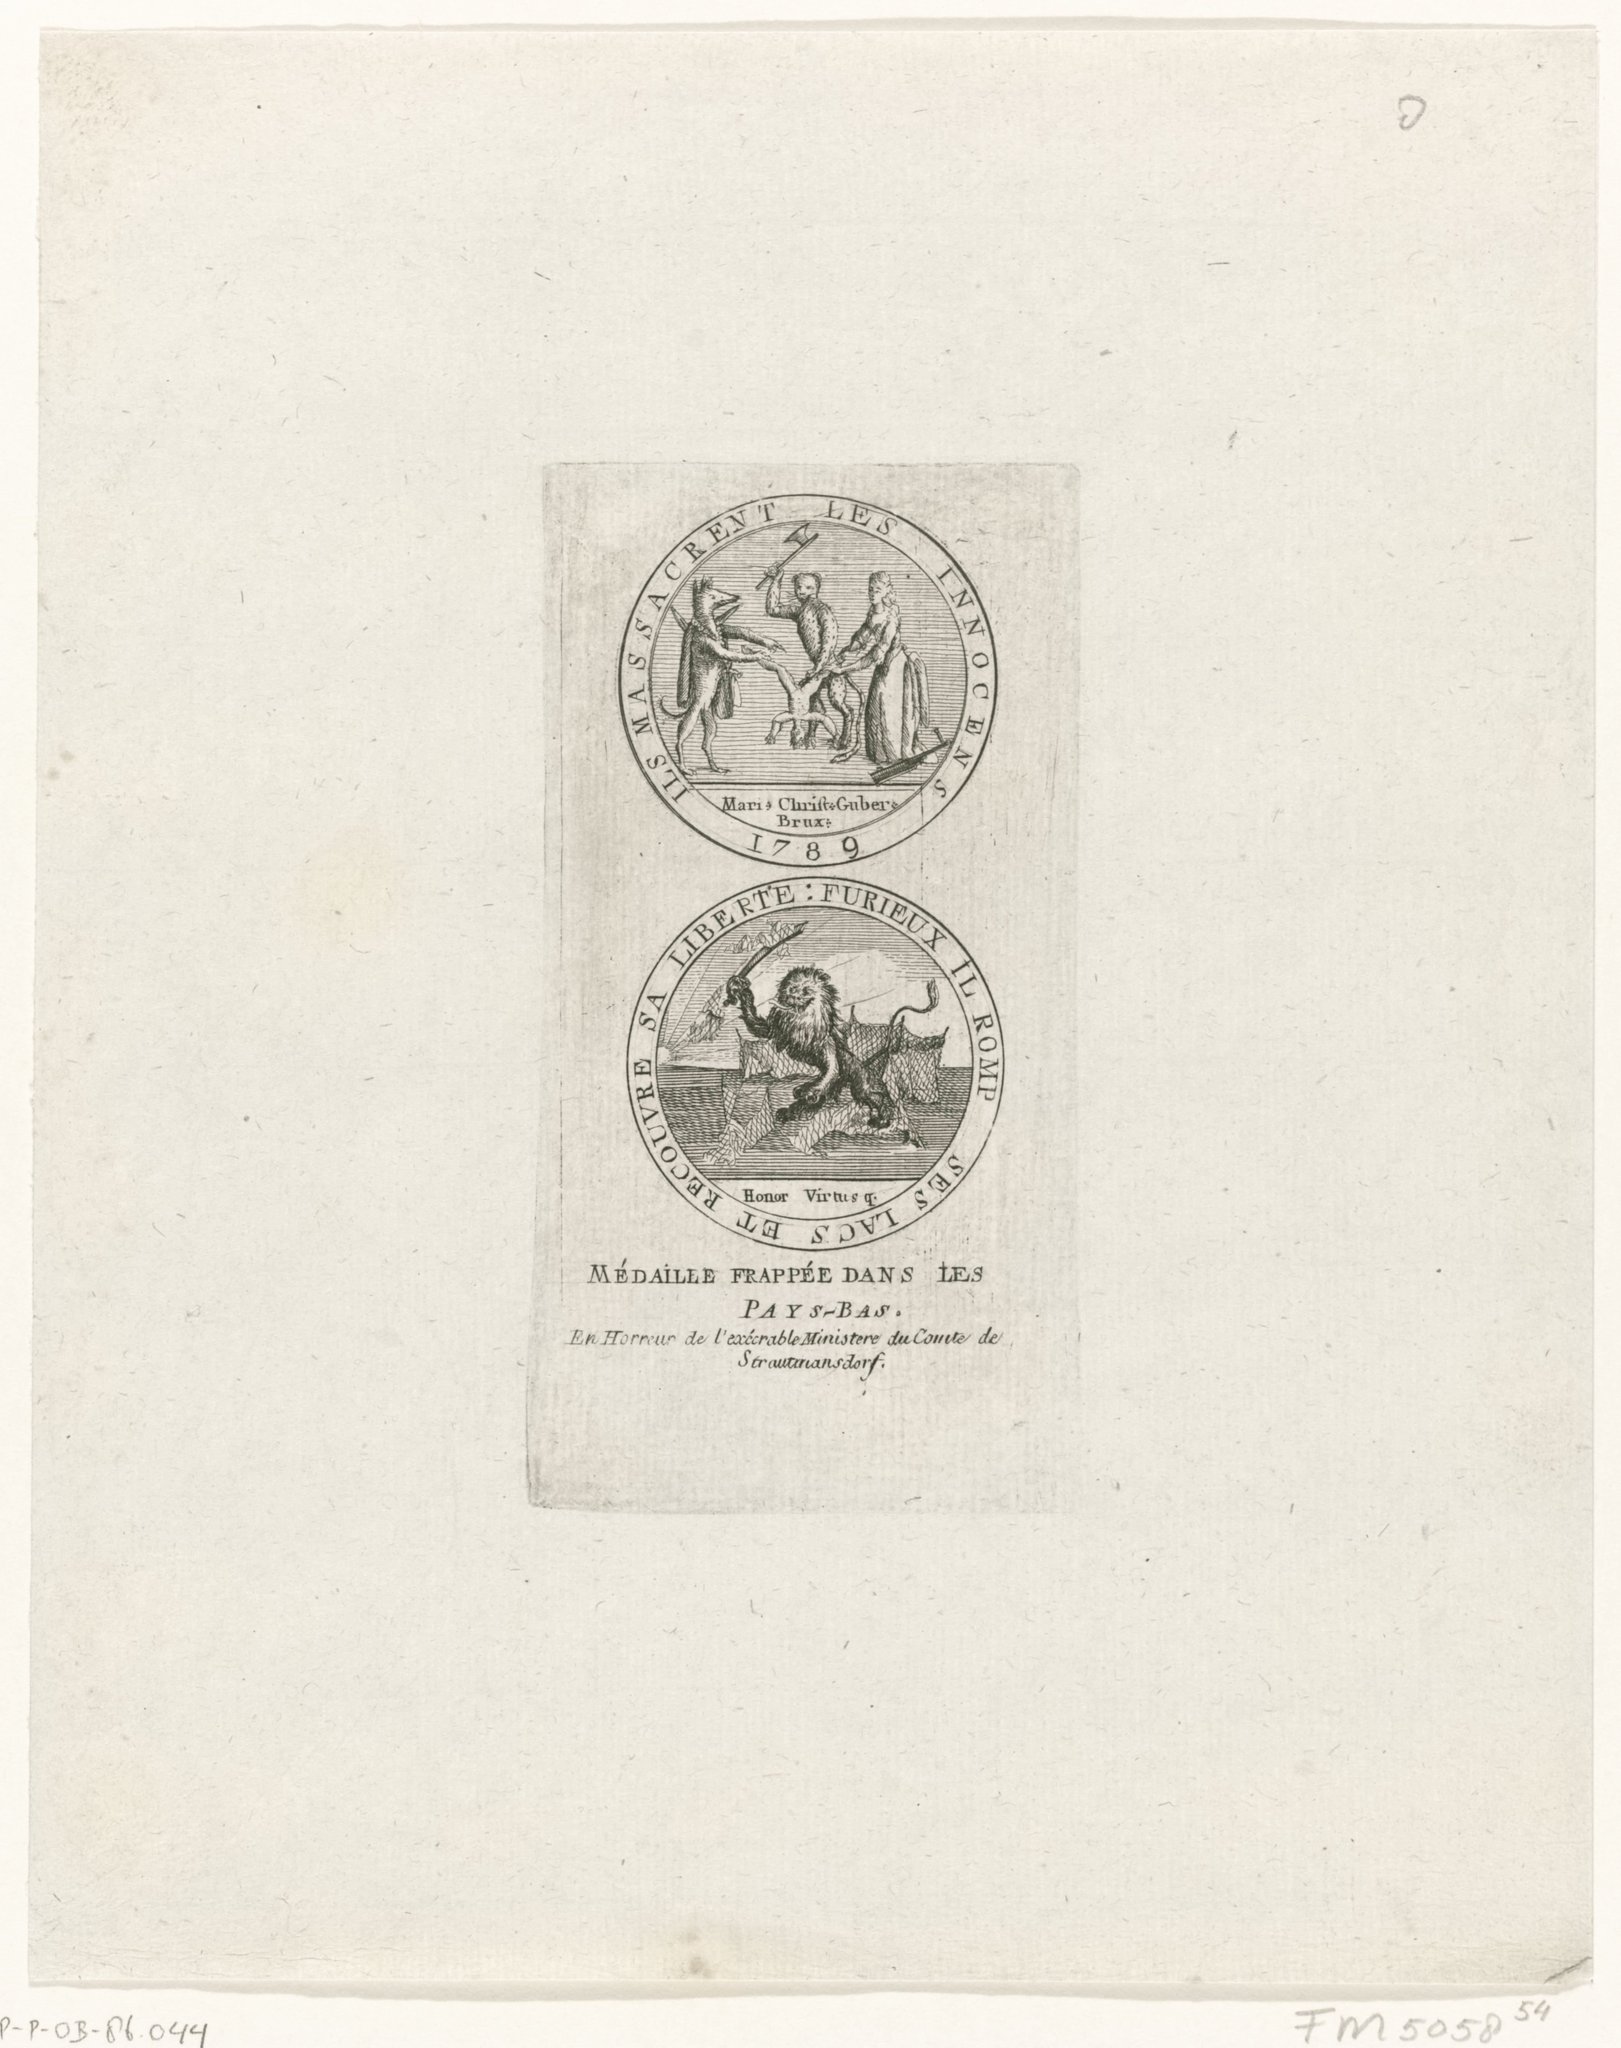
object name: print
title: Médaille frappée dans les Pays-Bas. En Horreur de l'exécrable Ministre du Comte de Strautmansdorf (Trautmansdorff)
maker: Anonymous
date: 1787-1790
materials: paper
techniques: engraving, etching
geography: southern netherlands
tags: vienna, medal (considered as a piece of sculpture, regardless of its specific function), brabant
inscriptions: collector's mark: Lugt 2228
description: Beide zijden van een penning tegen de wreedheden bedreven in Brabant; met de datum 16 augustus 1789. Op de voorzijde houden een wolf en een vrouw een kind vast dat doormidden wordt gehakt door een luipaard. Op de keerzijde bevrijdt de Brabantse leeuw zich uit een net. In het onderschrift wordt er verwezen naar landvoogd Trauttmansdorff. Onderdeel van een grote groep van prenten betrekking hebbend op de gebeurtenissen van de Brabantse Omwenteling en de periode 1787-1790.